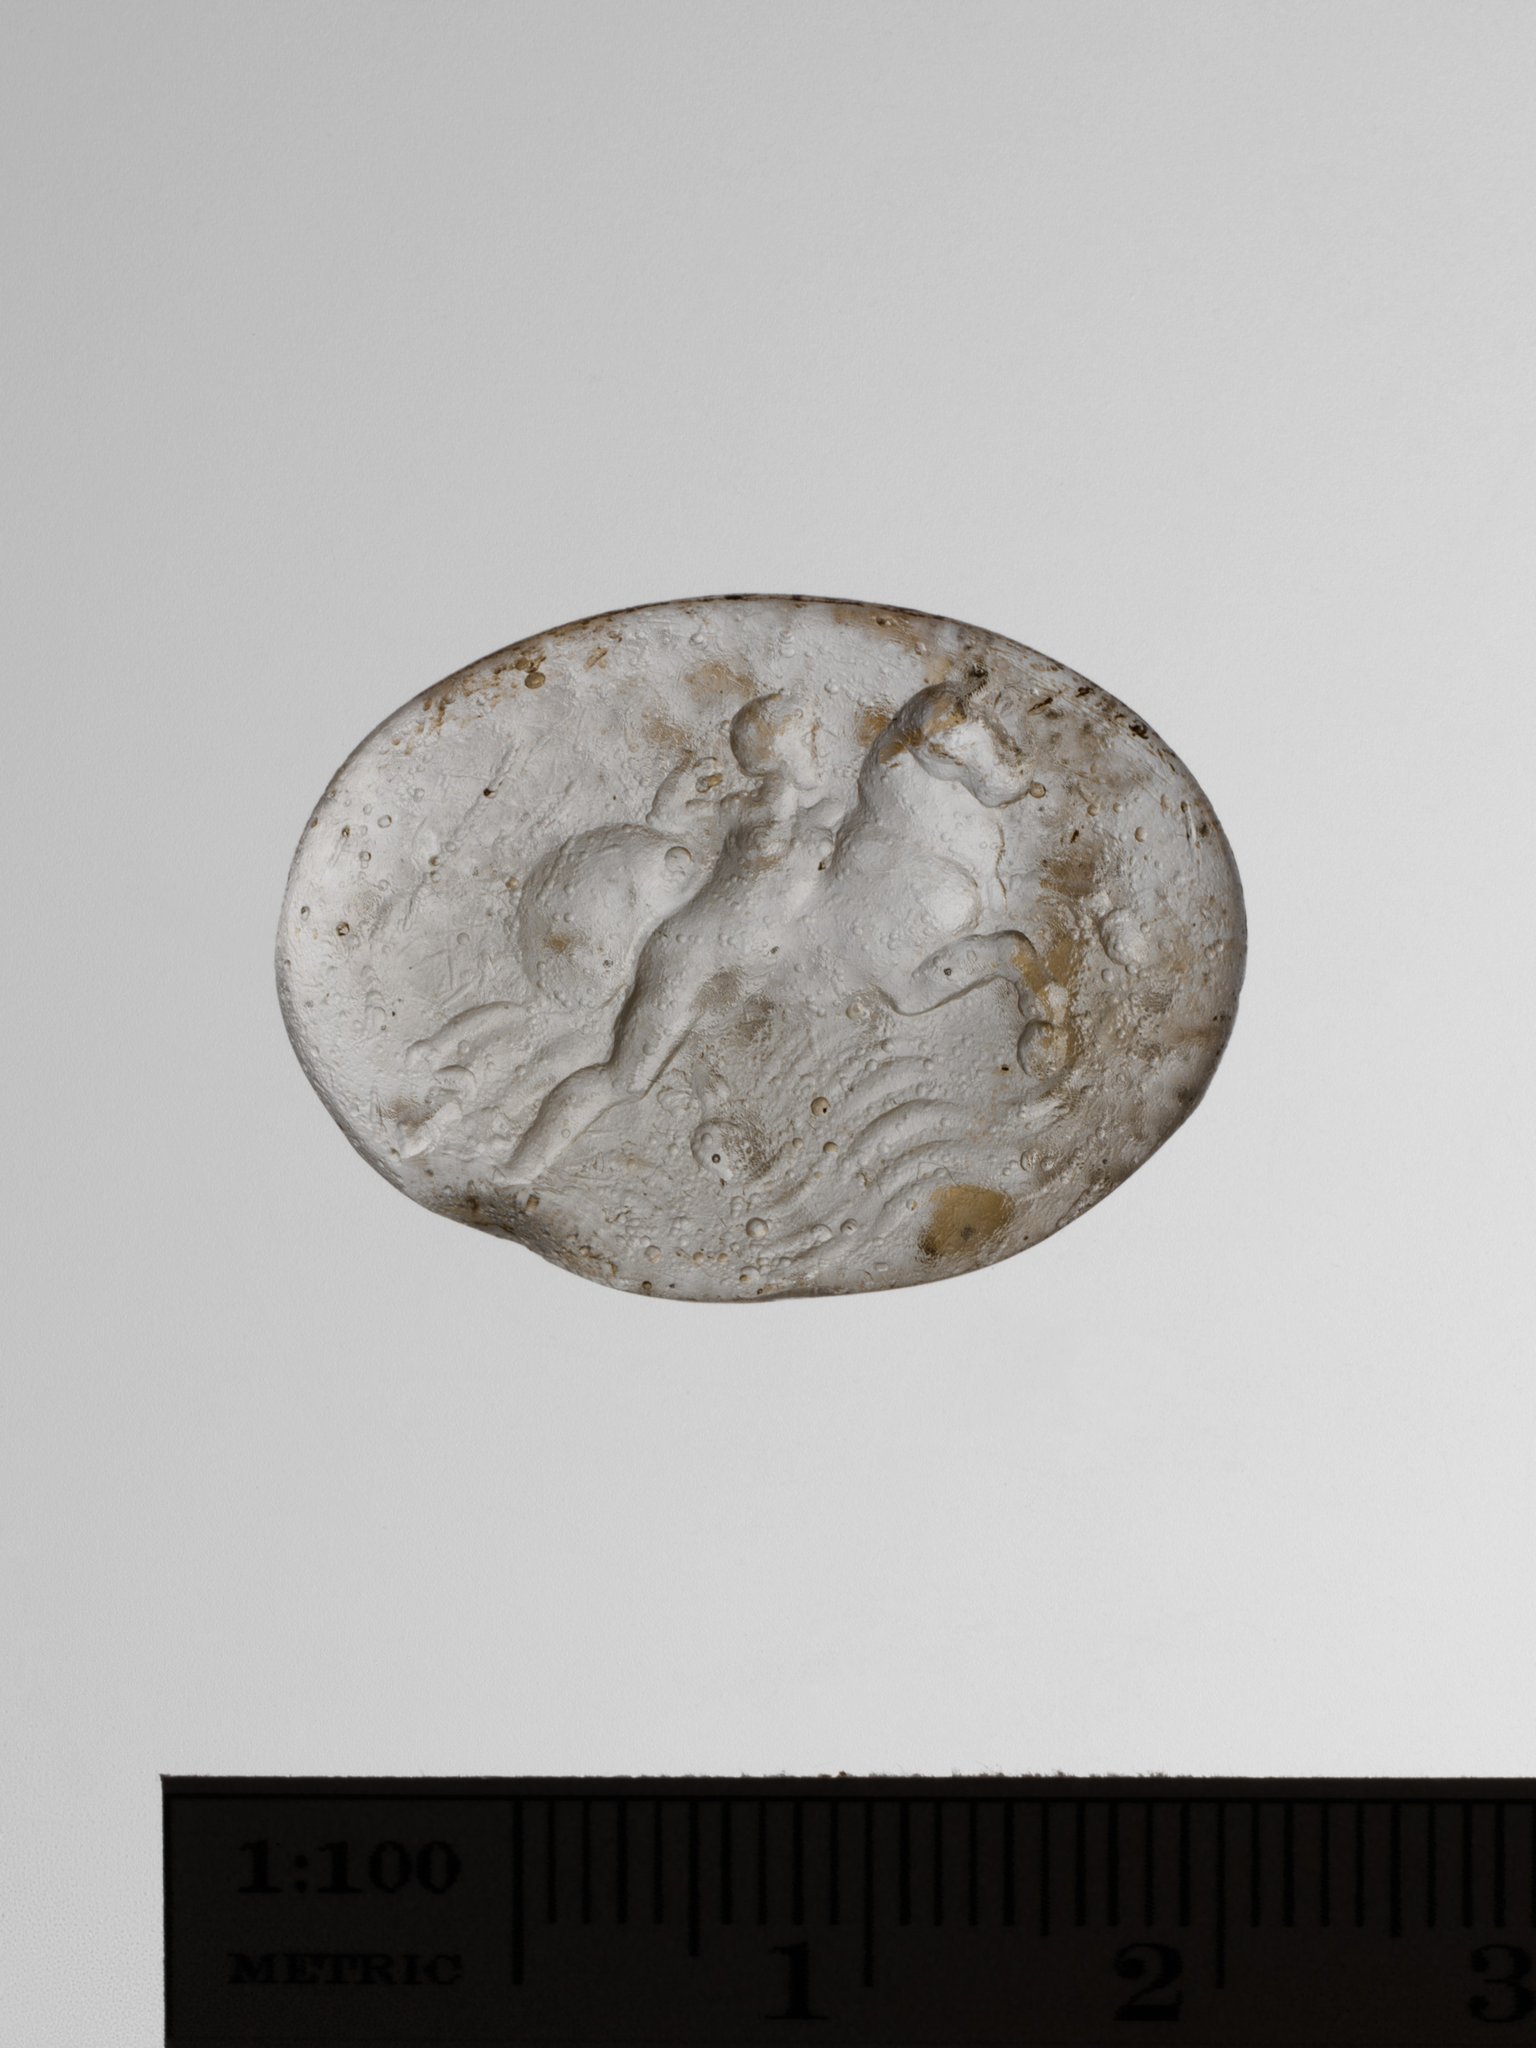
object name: intaglio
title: Yellow glass ring stone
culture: roman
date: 1-100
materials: glass, paste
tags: europa,bulls